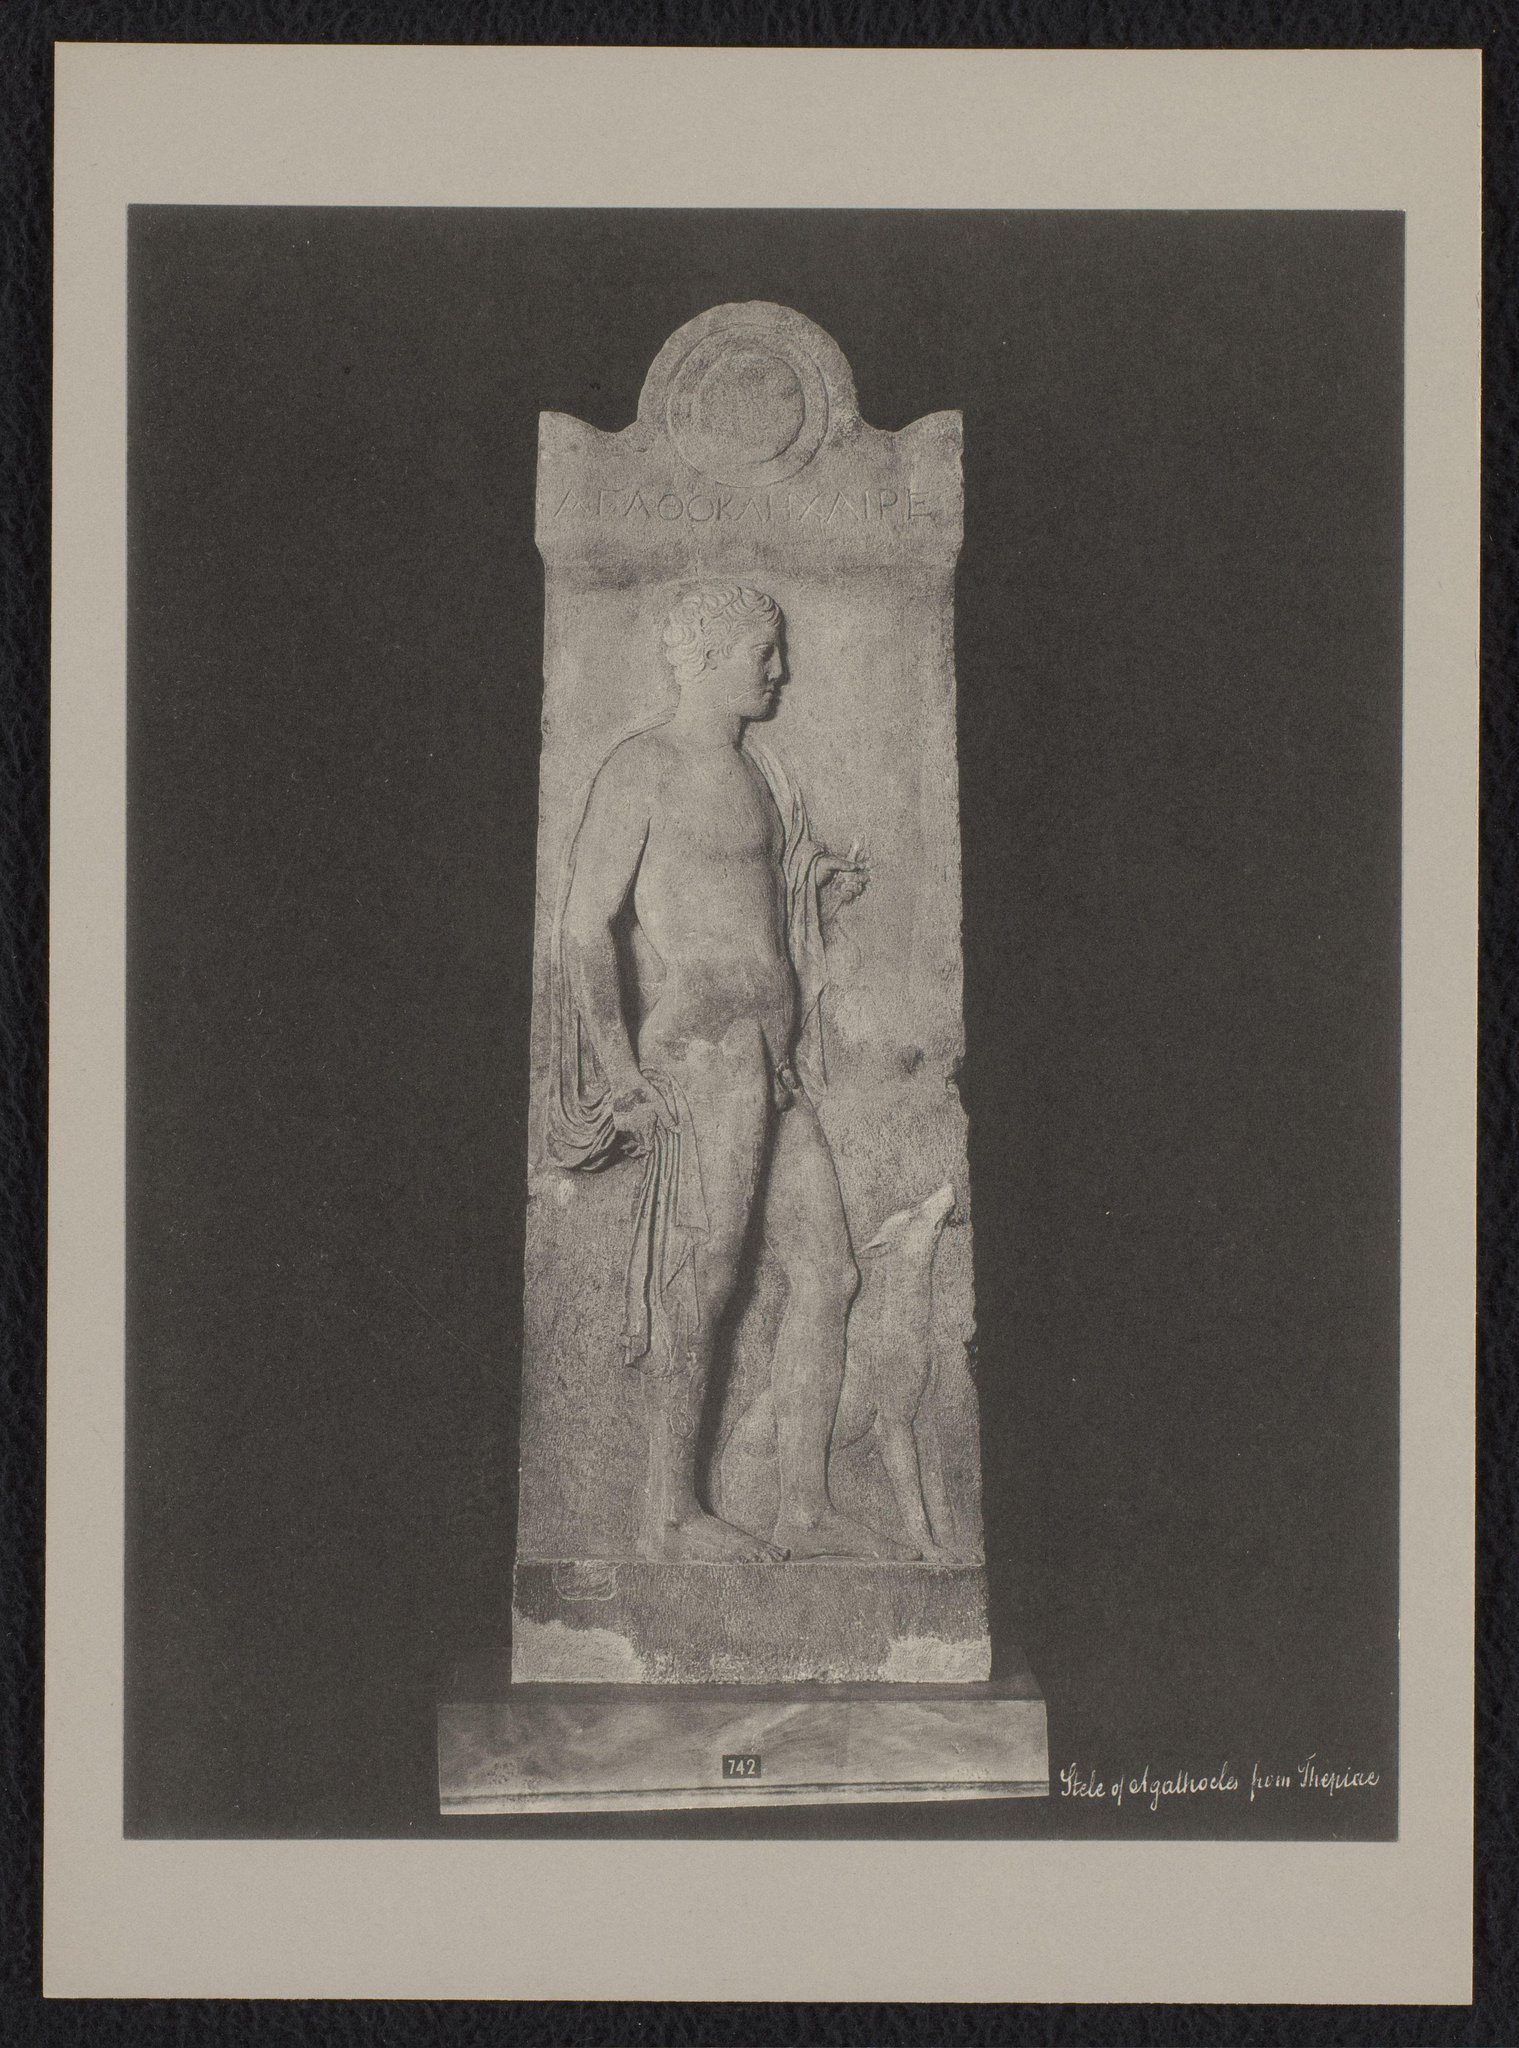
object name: photograph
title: Stele of Agathocles from Thepiae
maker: Anonymous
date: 1895-1915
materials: cardboard, paper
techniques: photograph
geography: athens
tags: athene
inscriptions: number: ‘38.’